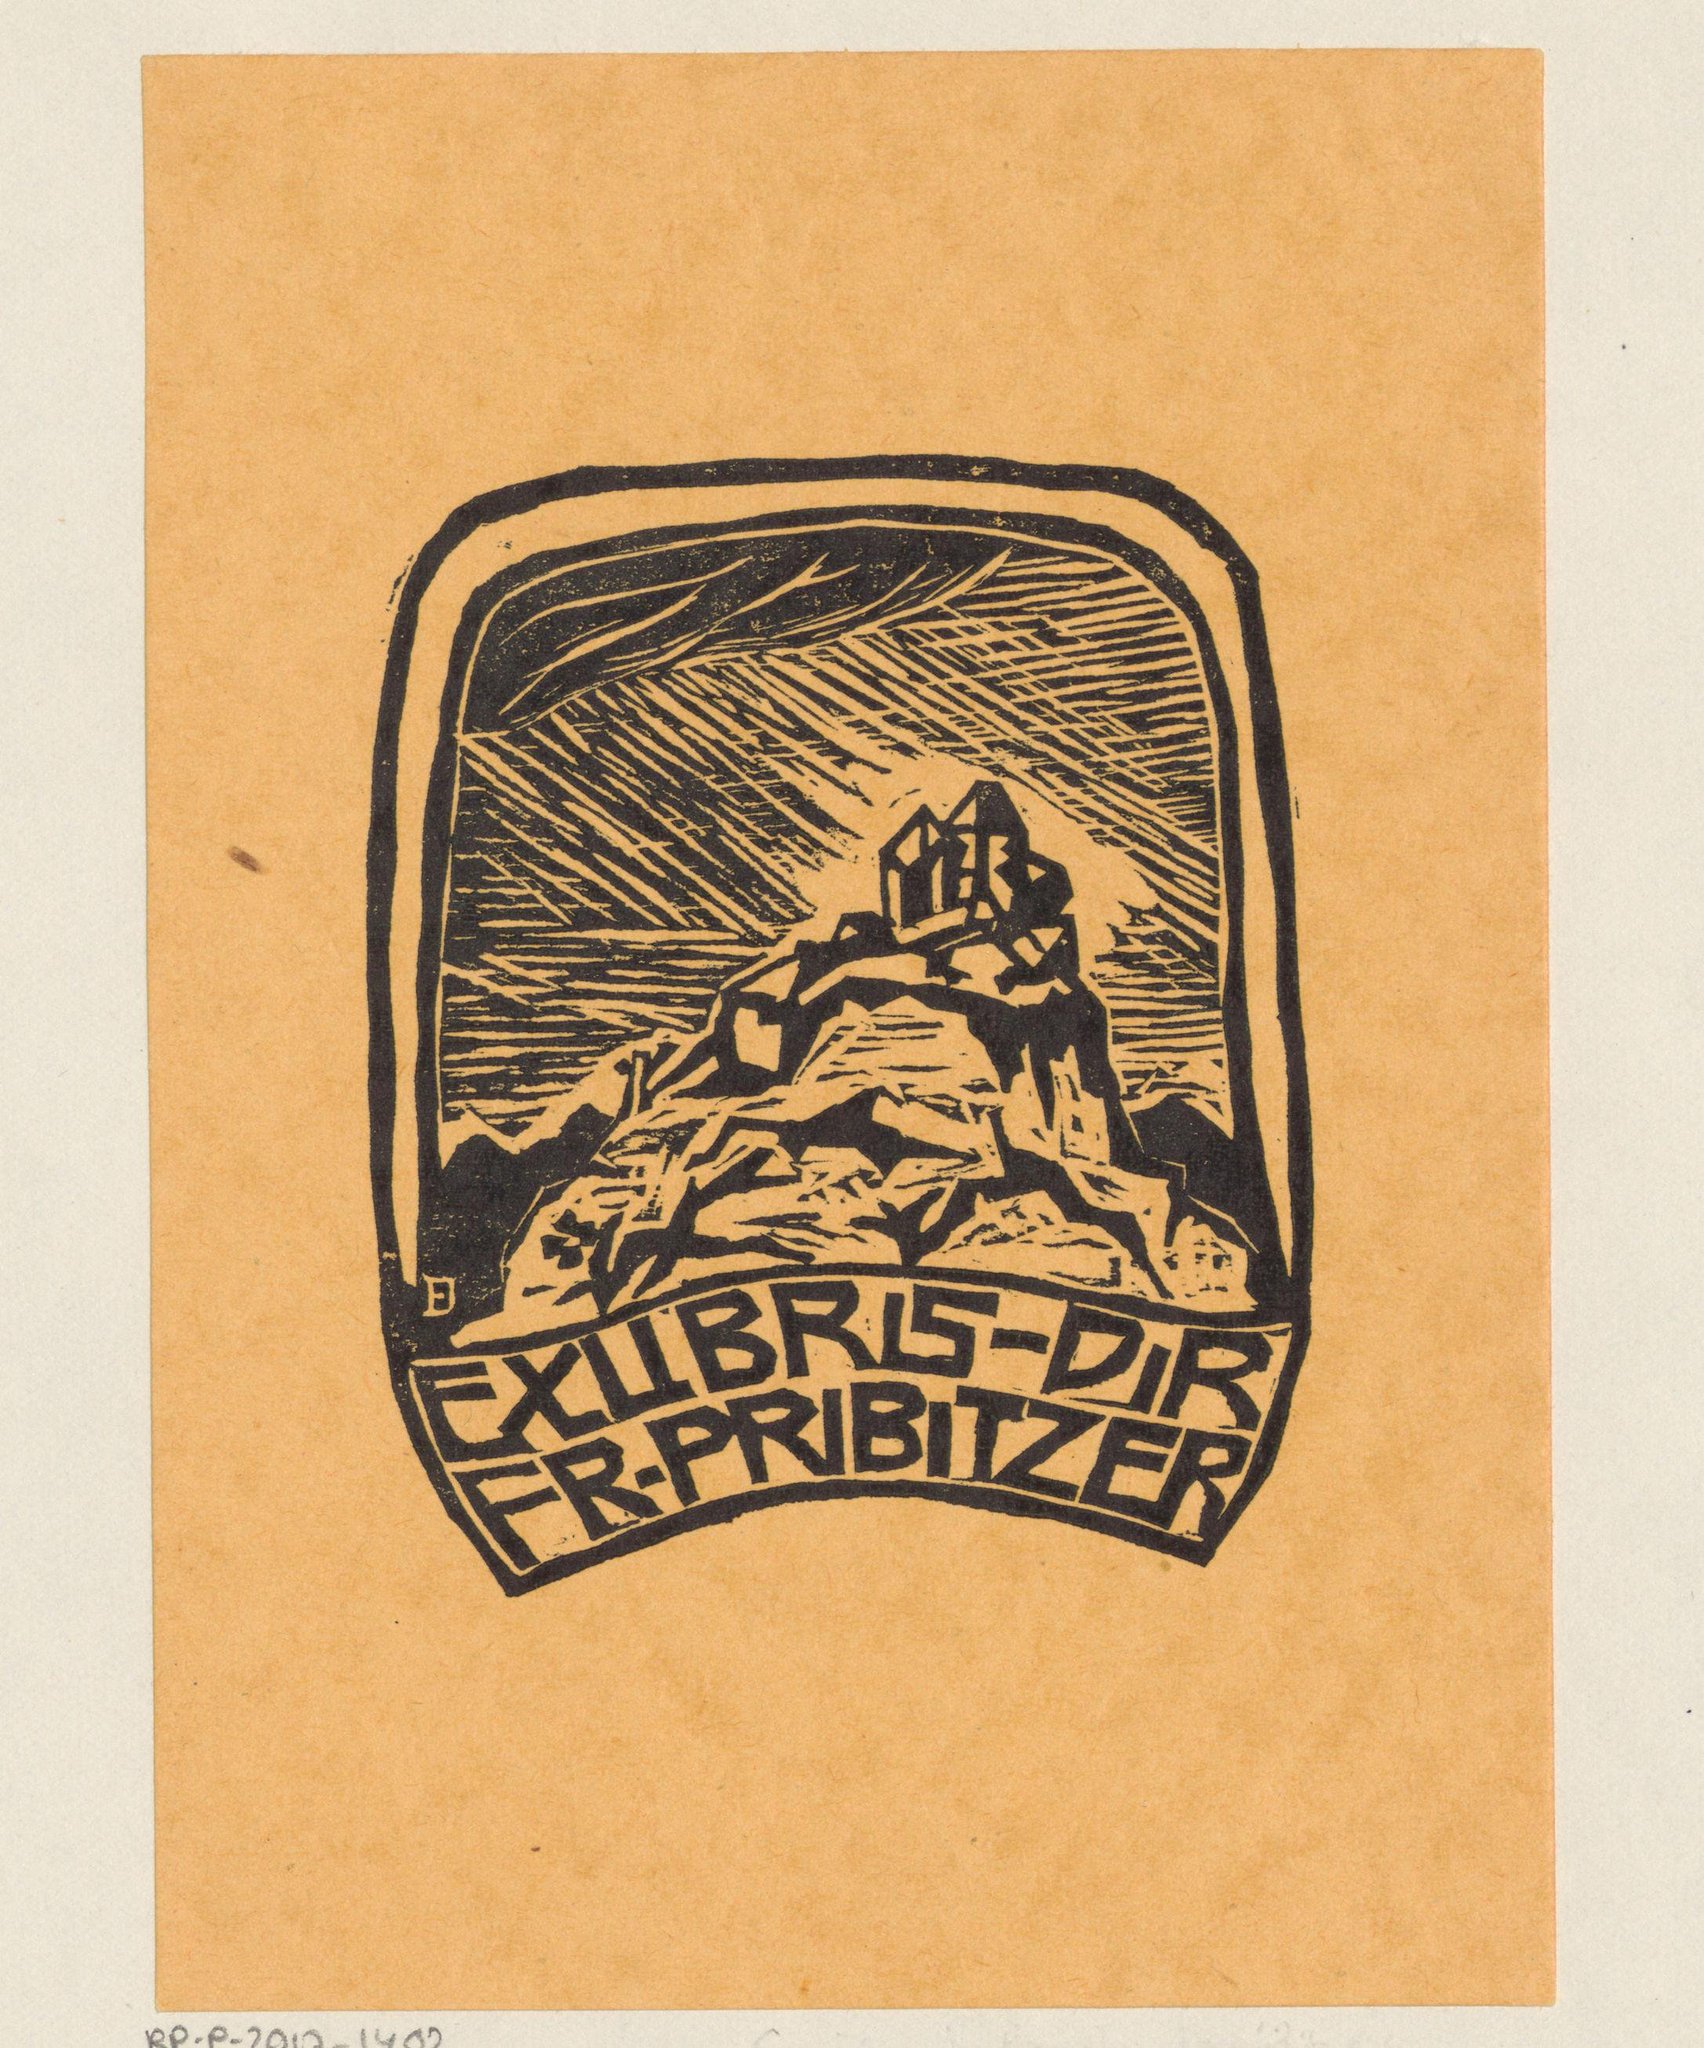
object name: bookplate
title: Ex libris van Fr. Pribitzer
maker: emil doepler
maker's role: painter, print maker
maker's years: 1855-1922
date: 1932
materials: paper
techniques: woodcut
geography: germany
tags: rain, rock-formations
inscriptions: inscription: ‘Holzschnitt Emil Doeppler [...]folk (?) 1932’